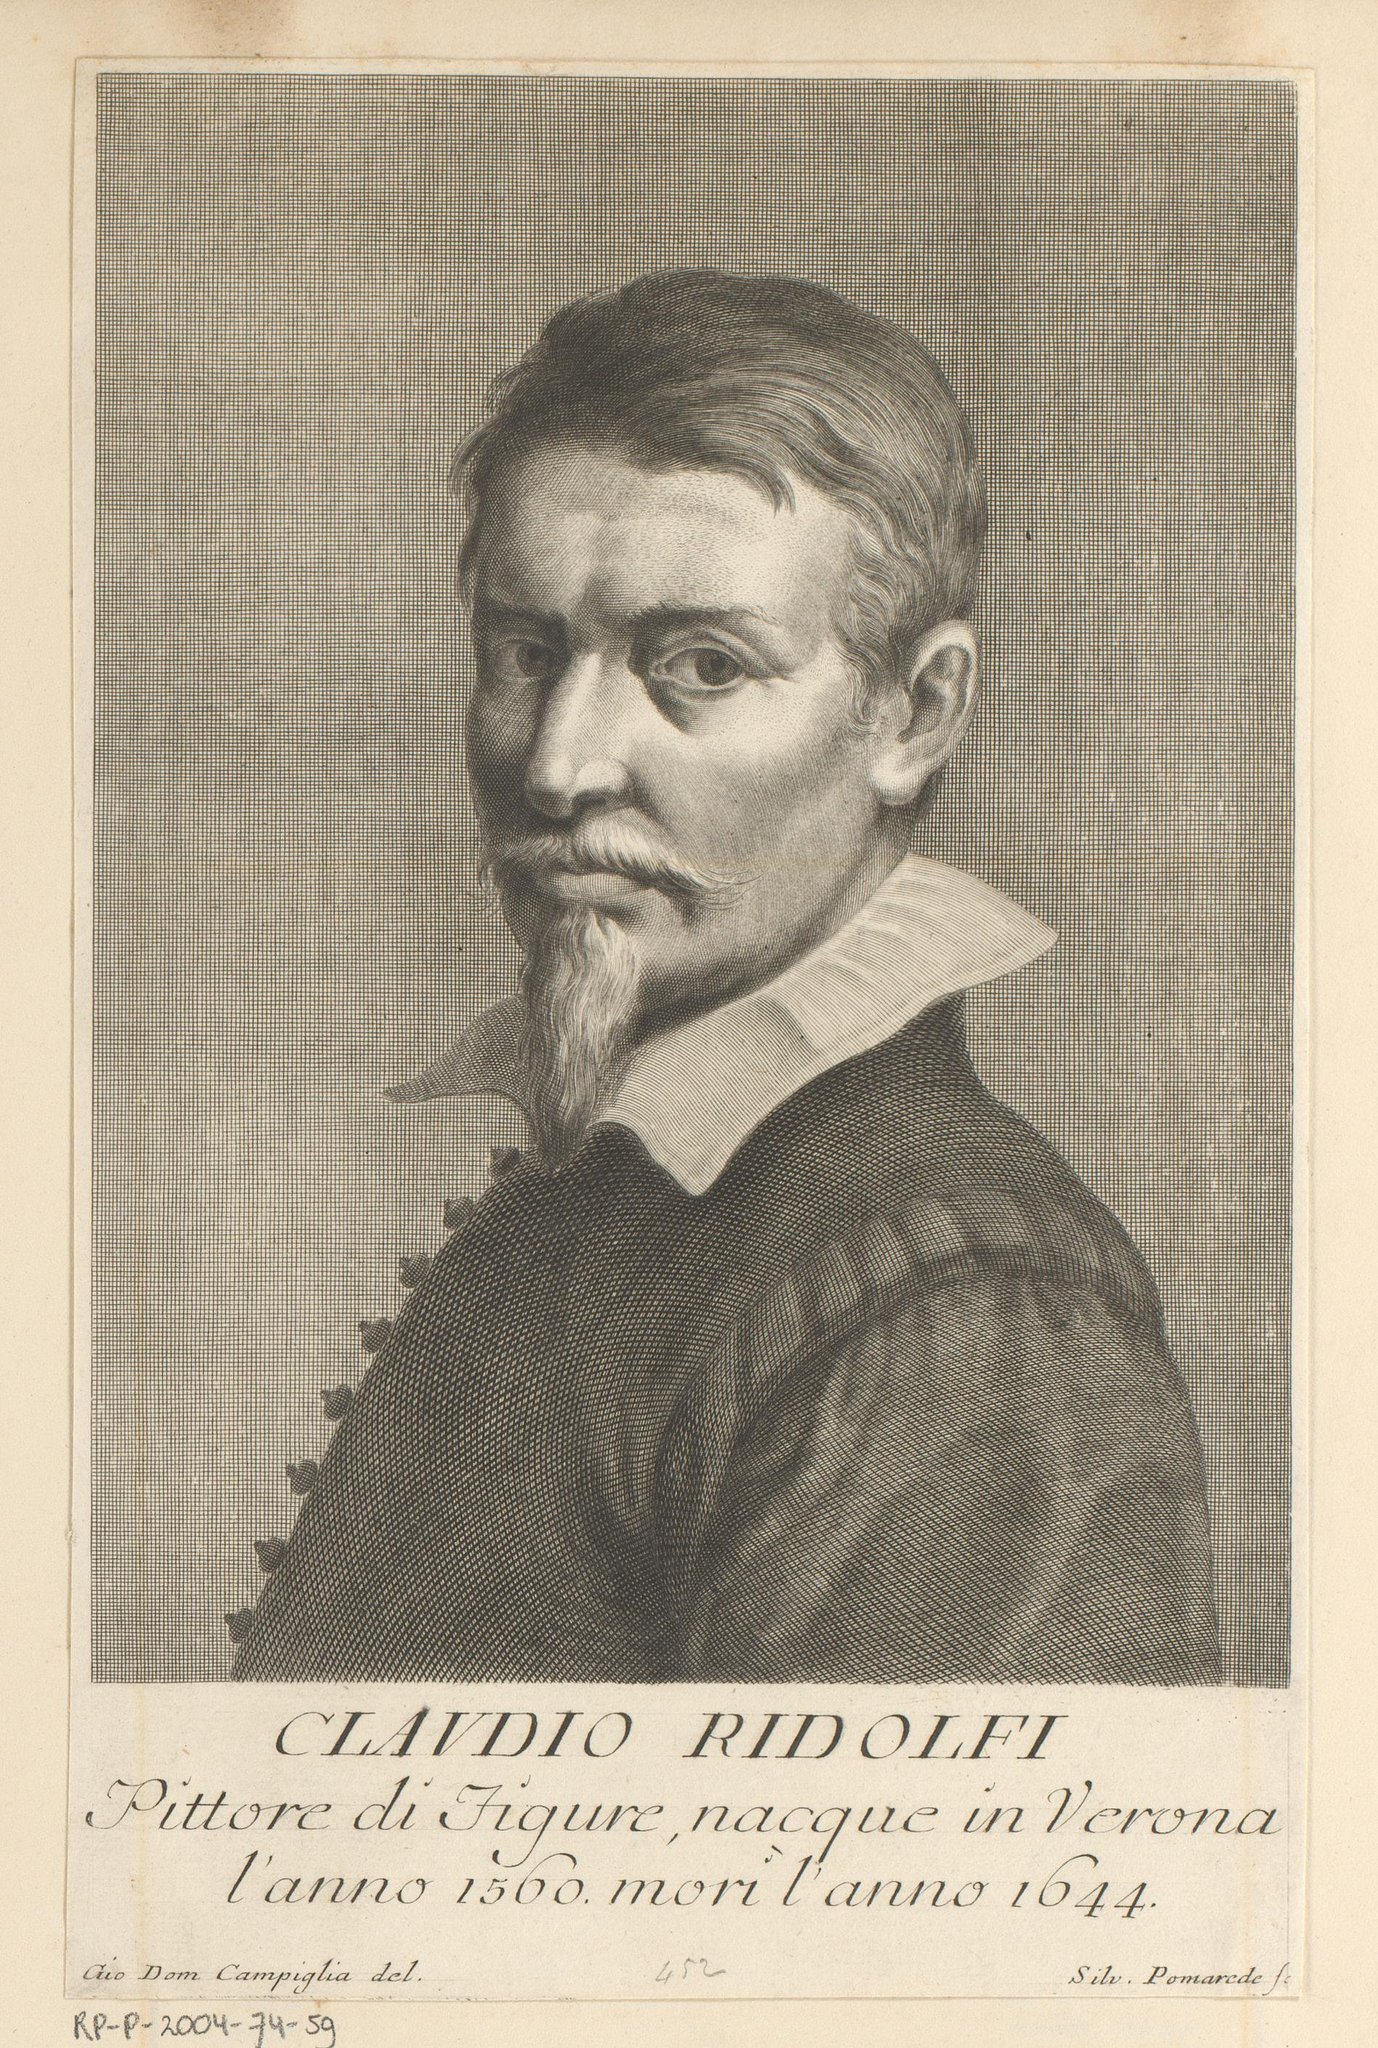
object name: print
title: Portret van Claudio Ridolfi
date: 1754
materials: paper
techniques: engraving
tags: painter, artist, claudio ridolfi, historical persons, portrait, self-portrait of painter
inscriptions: date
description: Prent mogelijk gebruikt in: : Moücke, Francesco. Serie di ritratti degli eccellenti pittori : dipinti di propria mano che esistono nell'Imperial galleria di Firenze. 4 dln. Florence: Francesco Moücke, 1754, dl. 2, p. 88. De samensteller heeft deze prent in het album geplakt als illustratie bij: Pilkington, Matthew en Johann Heinrich Füssli. A dictionary of painters, from the revival of the art to the present period. 4 dln. Londen: John Crowder, 1805, dl. 3, p. 452.